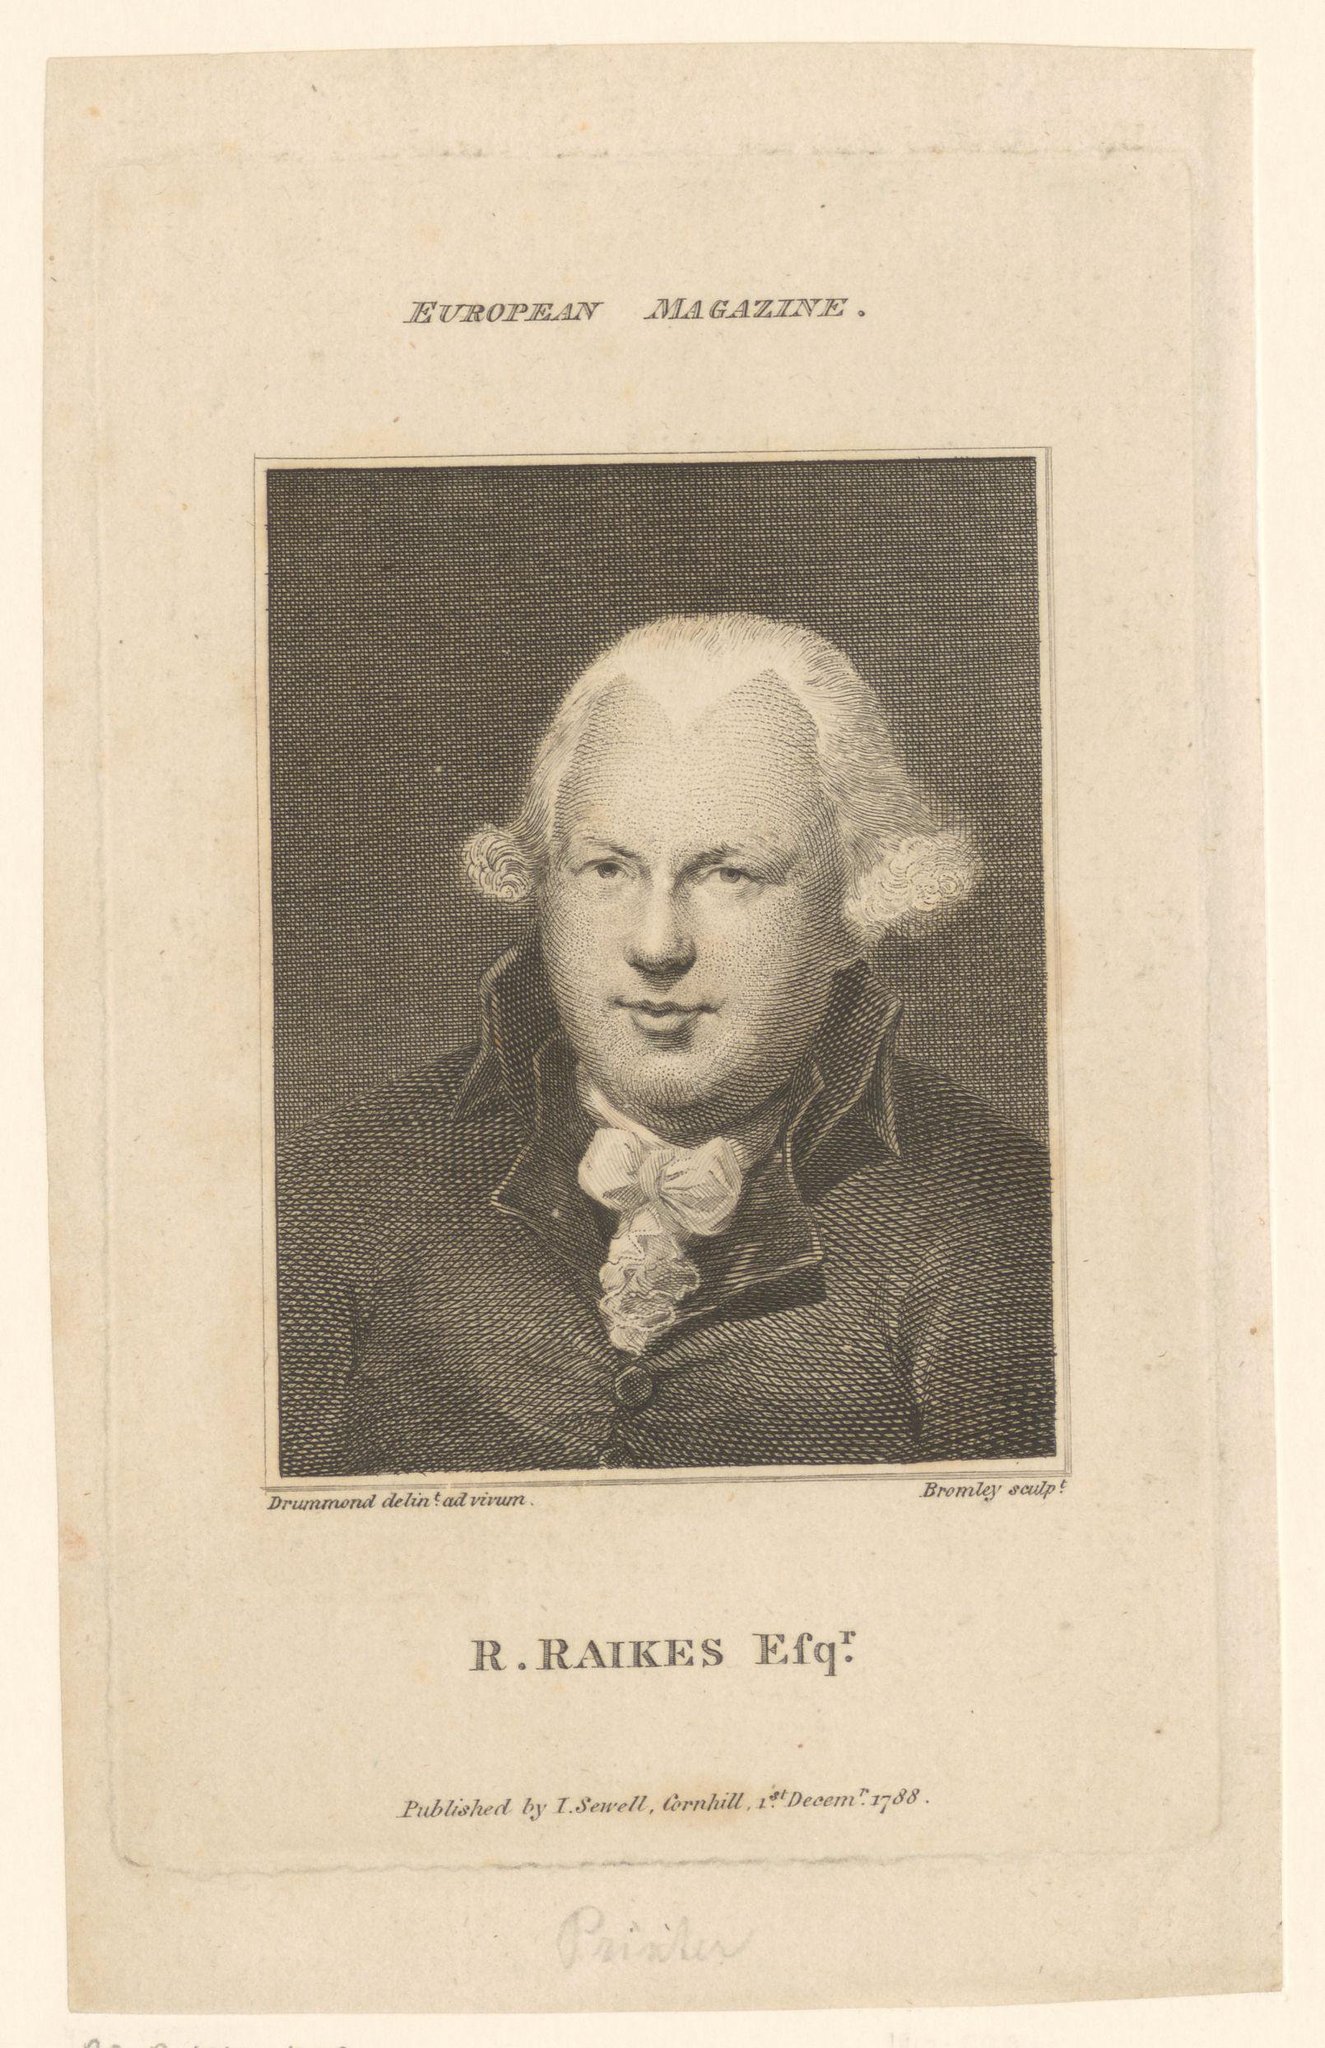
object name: print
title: Portret van Robert Raikes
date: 1712-1788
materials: paper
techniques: engraving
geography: london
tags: clergyman, historical persons, functionaries and dignitaries ~ episcopal protestant churches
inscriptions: collector's mark: Lugt 2228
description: Prent uit: The European Magazine, december 1788.